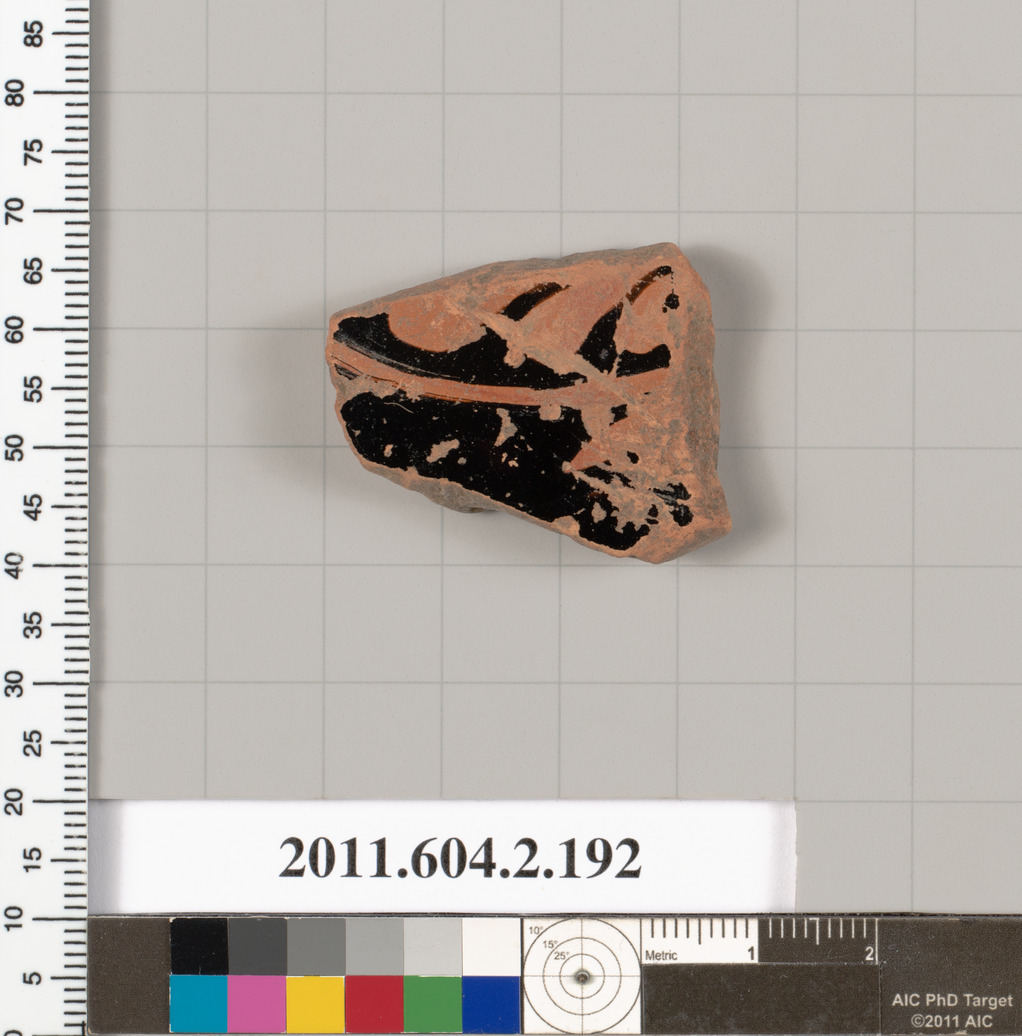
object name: stamnos fragment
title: Terracotta fragment of a stamnos (jar)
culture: greek, attic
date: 520-500 BCE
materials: terracotta